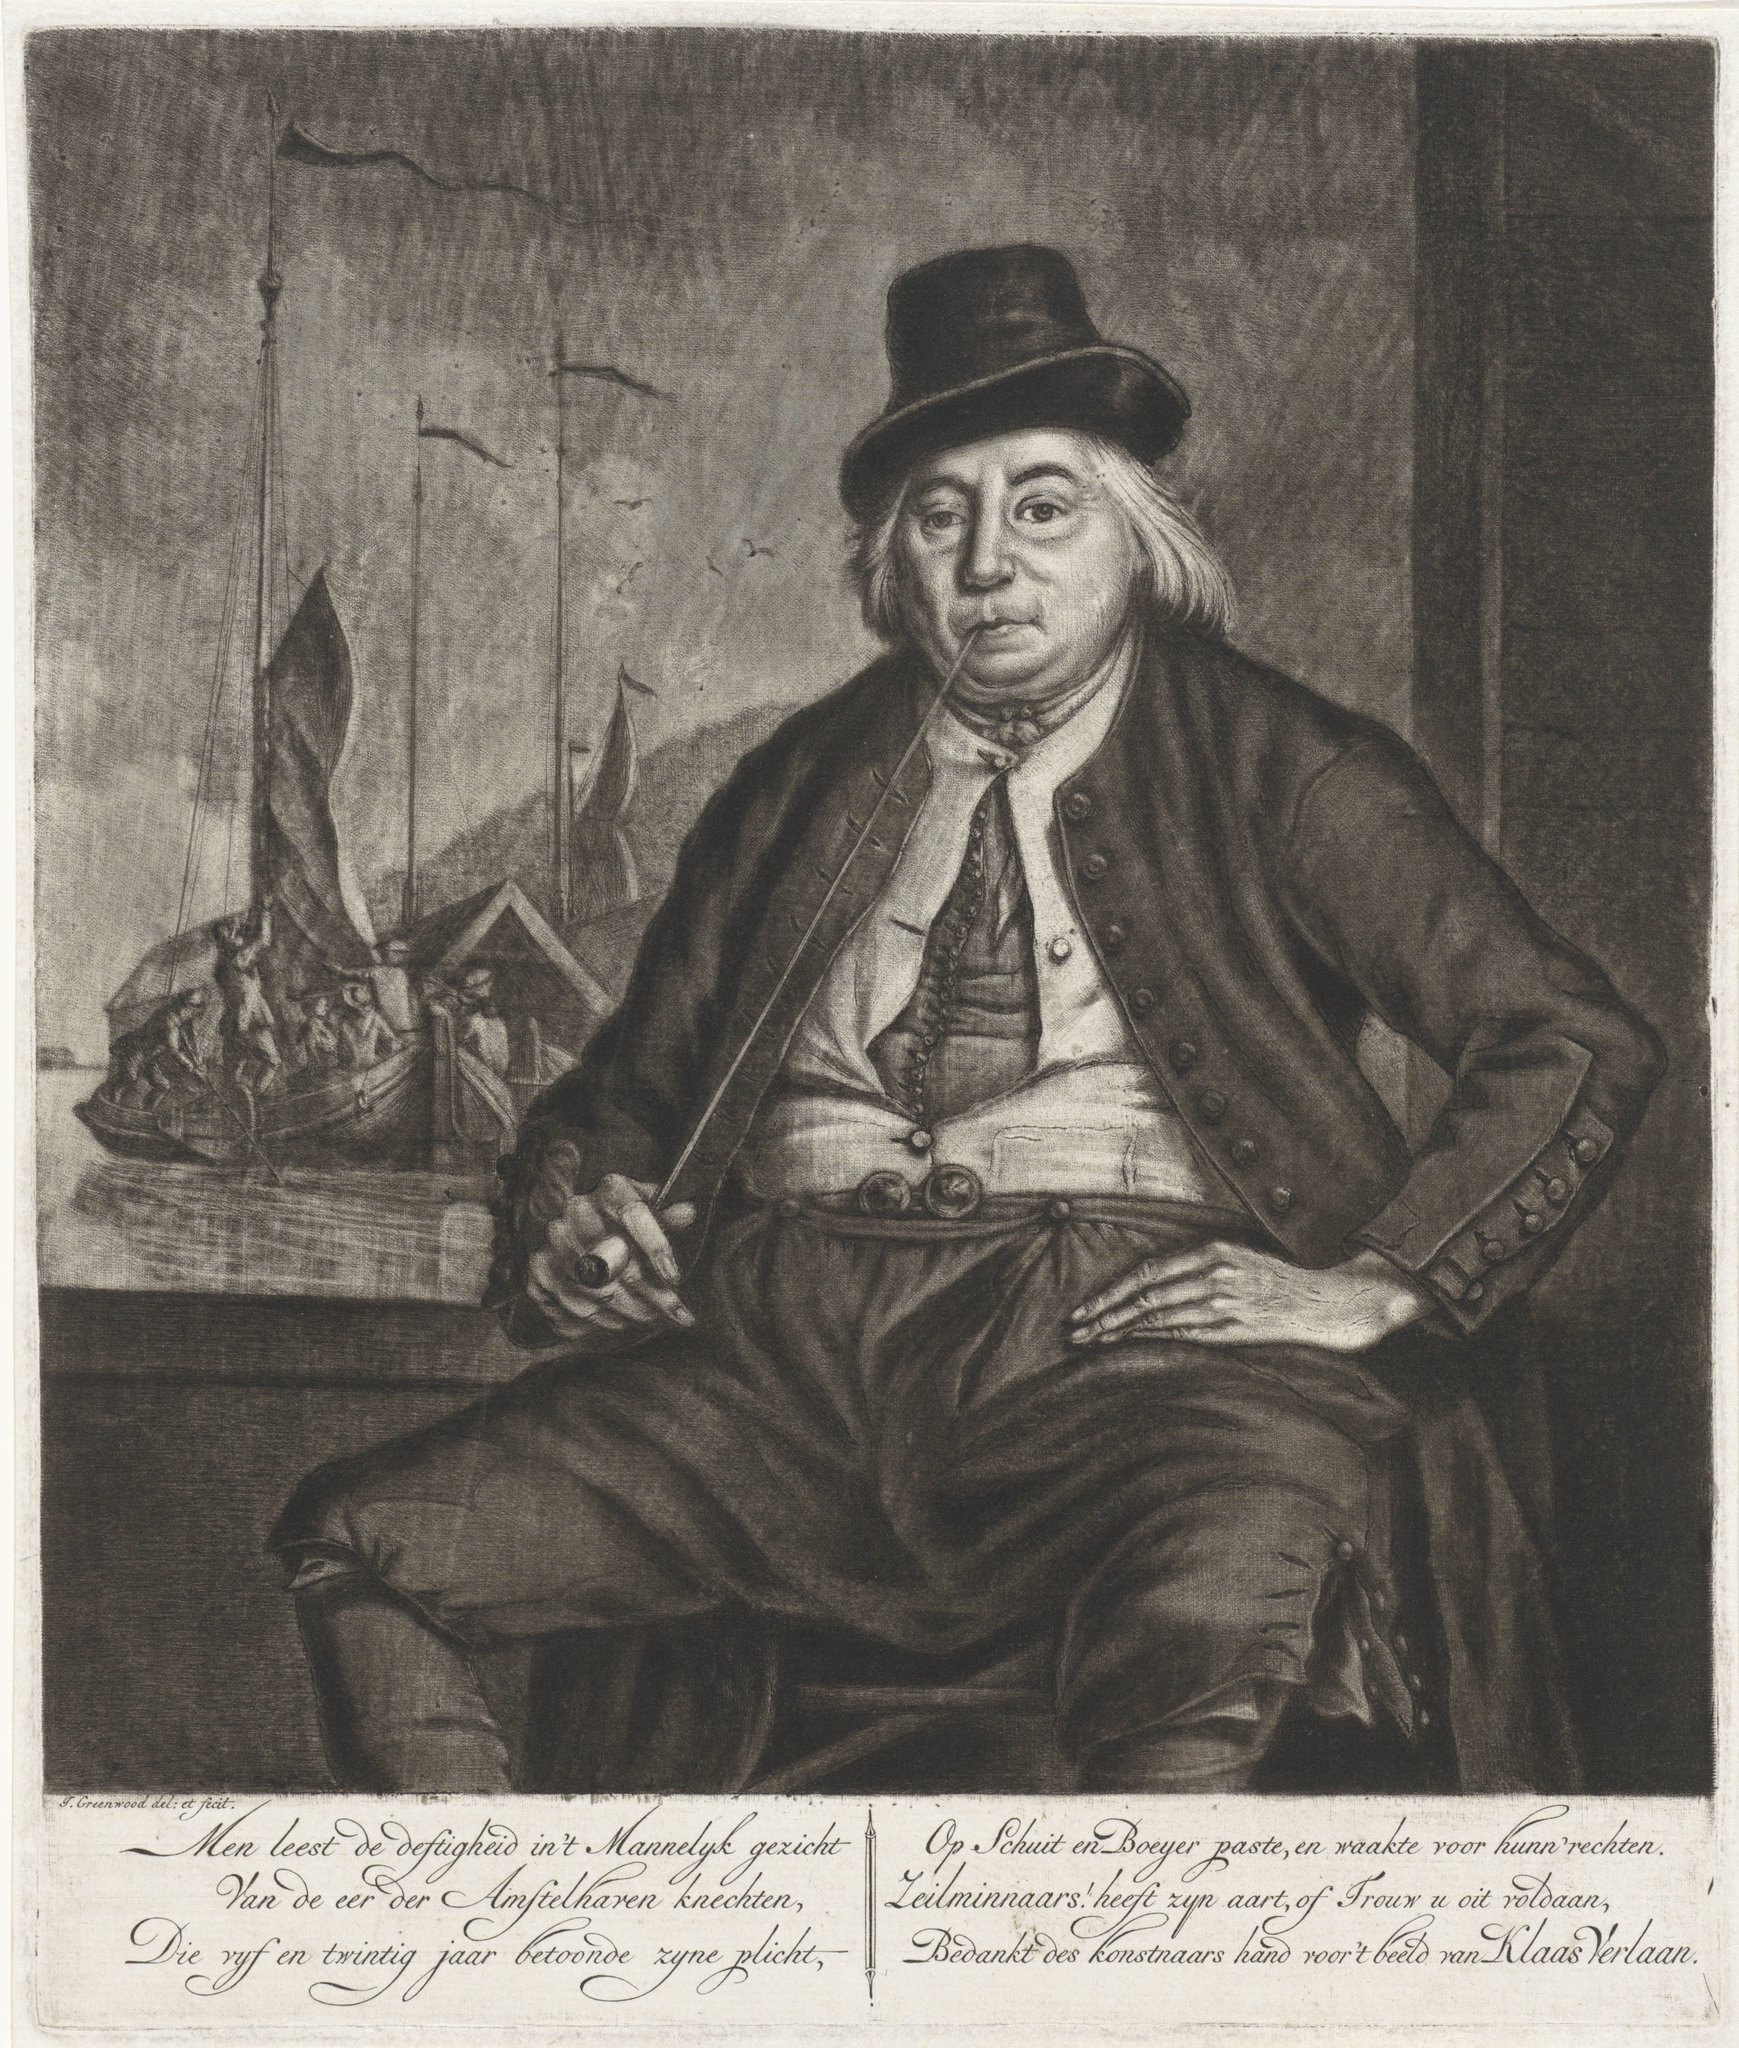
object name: print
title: Portret van Klaas Verlaan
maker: john greenwood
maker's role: auctioneer, draughtsman, print maker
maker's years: 1727-1792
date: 1739-1792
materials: paper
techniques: engraving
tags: sailing-ship, sailing-boat, pipe ~ tobacco, head-gear: hat (+ men's clothes)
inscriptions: collector's mark: Lugt 2228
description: Klaas Verlaan, knecht van de Amstel-jachthaven. Op het hoofd een hoed en in de rechterhand een lange pijp, waaruit hij rookt. Op de achtergrond de haven met jachten.